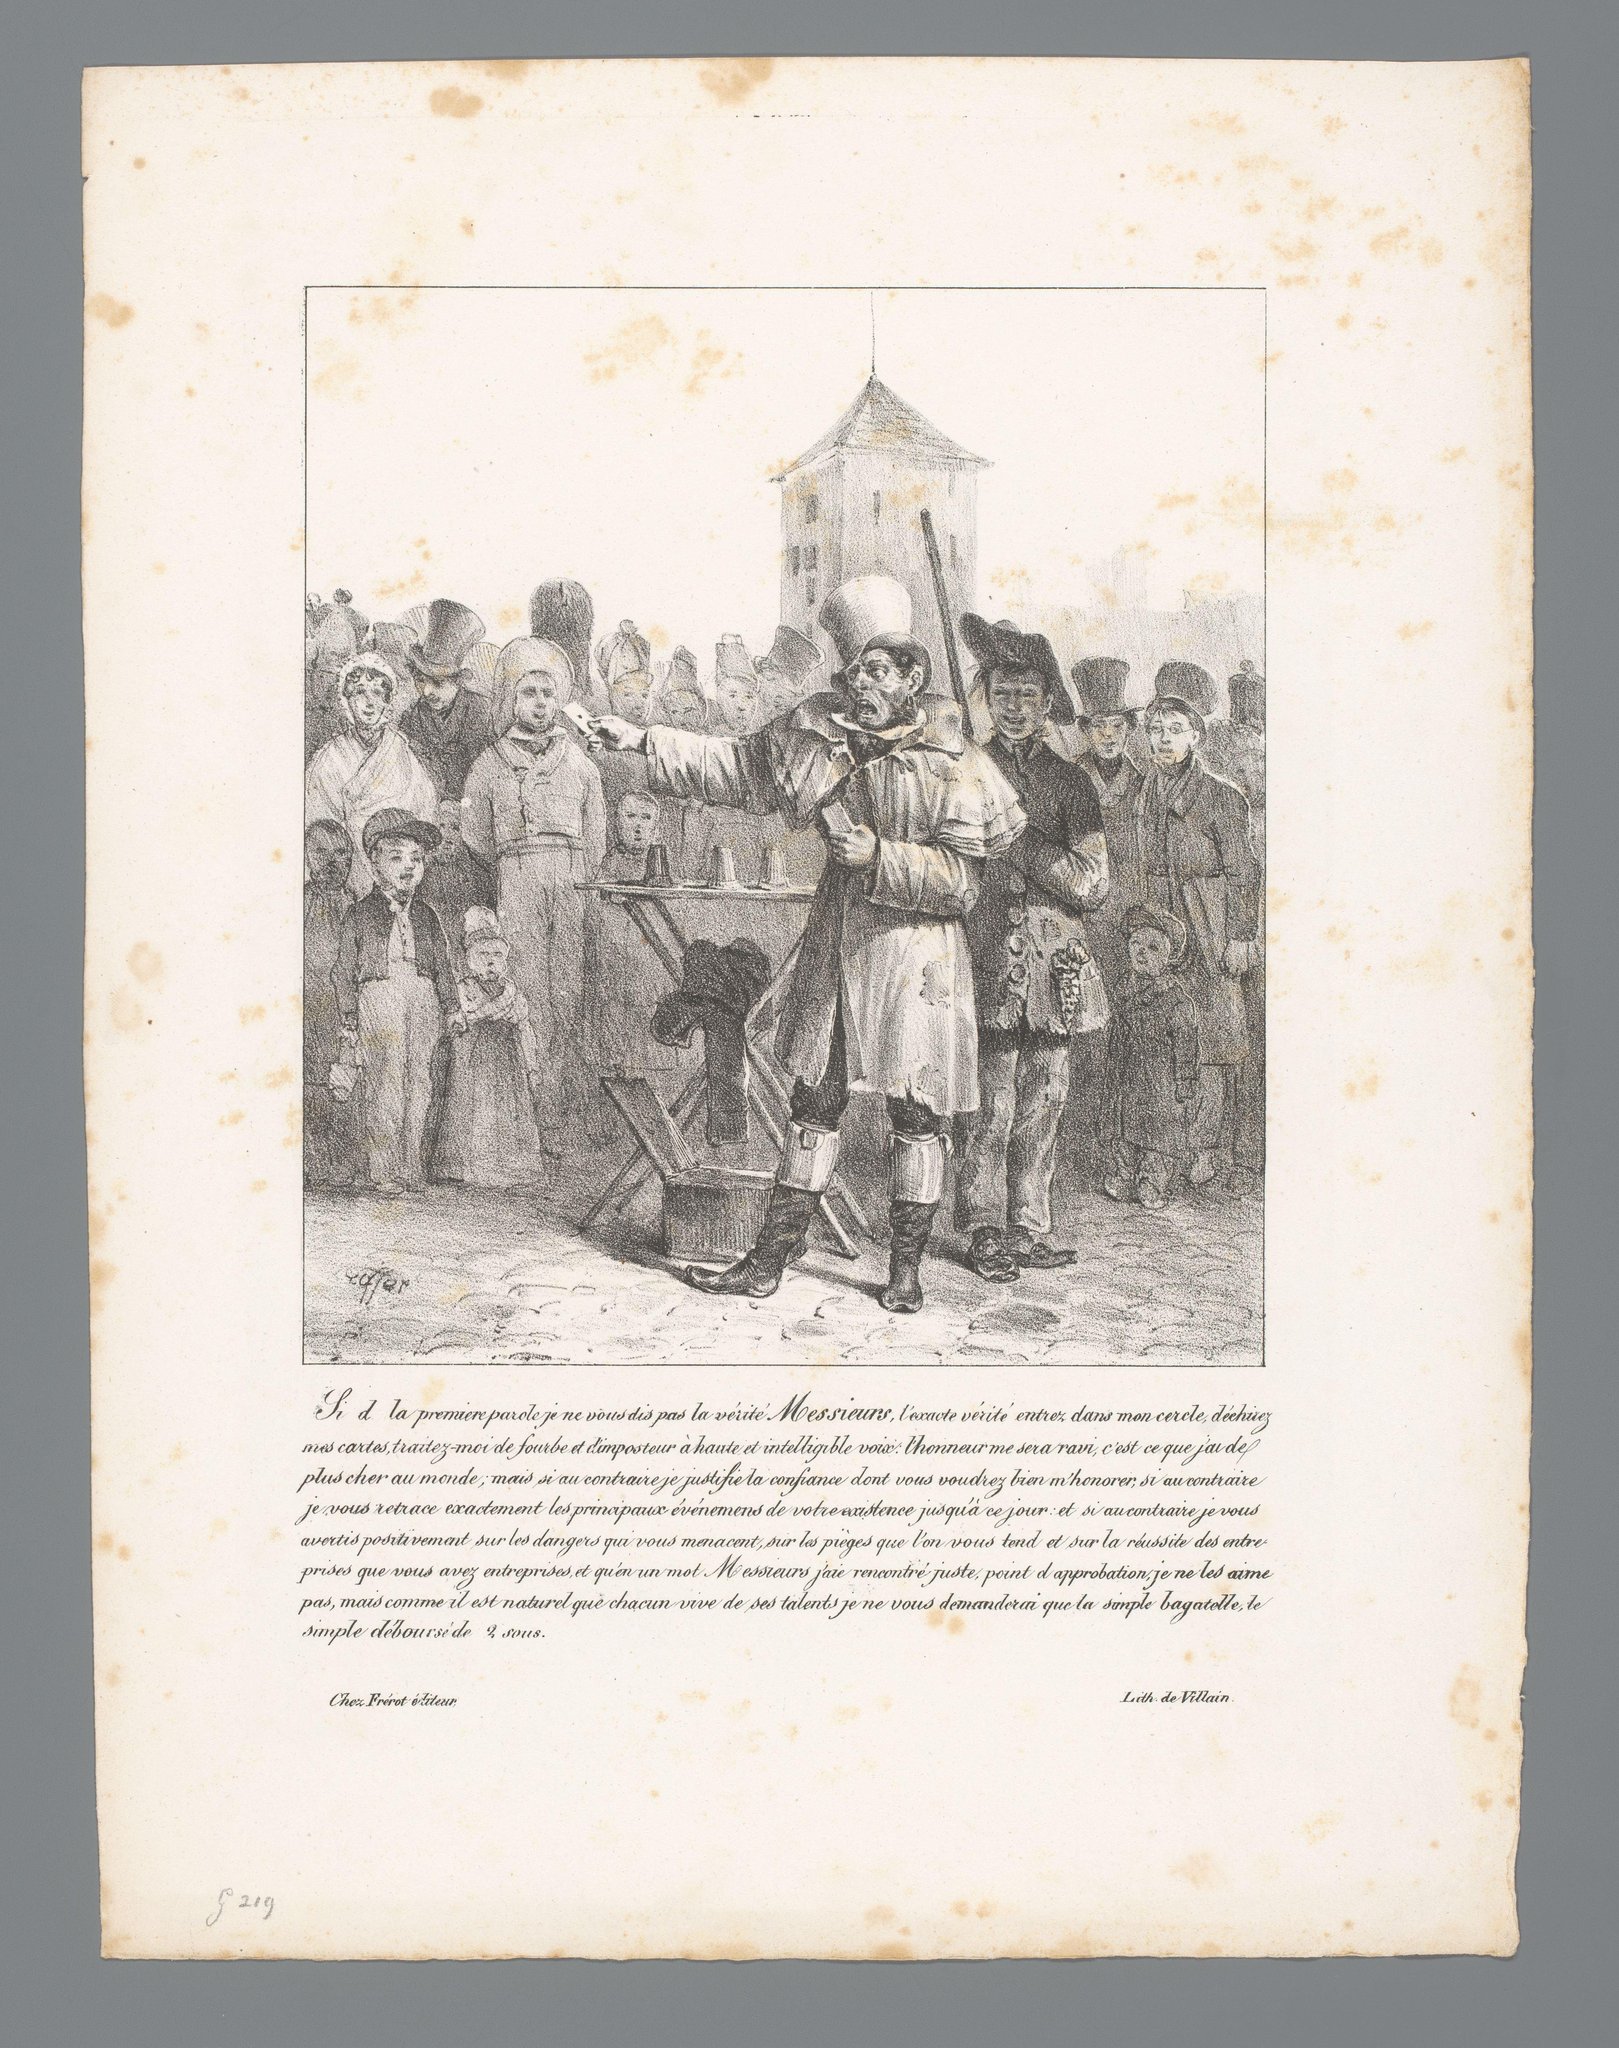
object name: print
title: Si d la premiere parole je ne vous dis pas la vérité messieurs, (...)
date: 1825-1829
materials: paper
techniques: lithograph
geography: paris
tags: sorcerer, magician, wizard, warlock, playing-cards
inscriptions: collector's mark: Lugt 964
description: Prent mogelijk verschenen in een onbekende serie uitgegeven door Frérot.